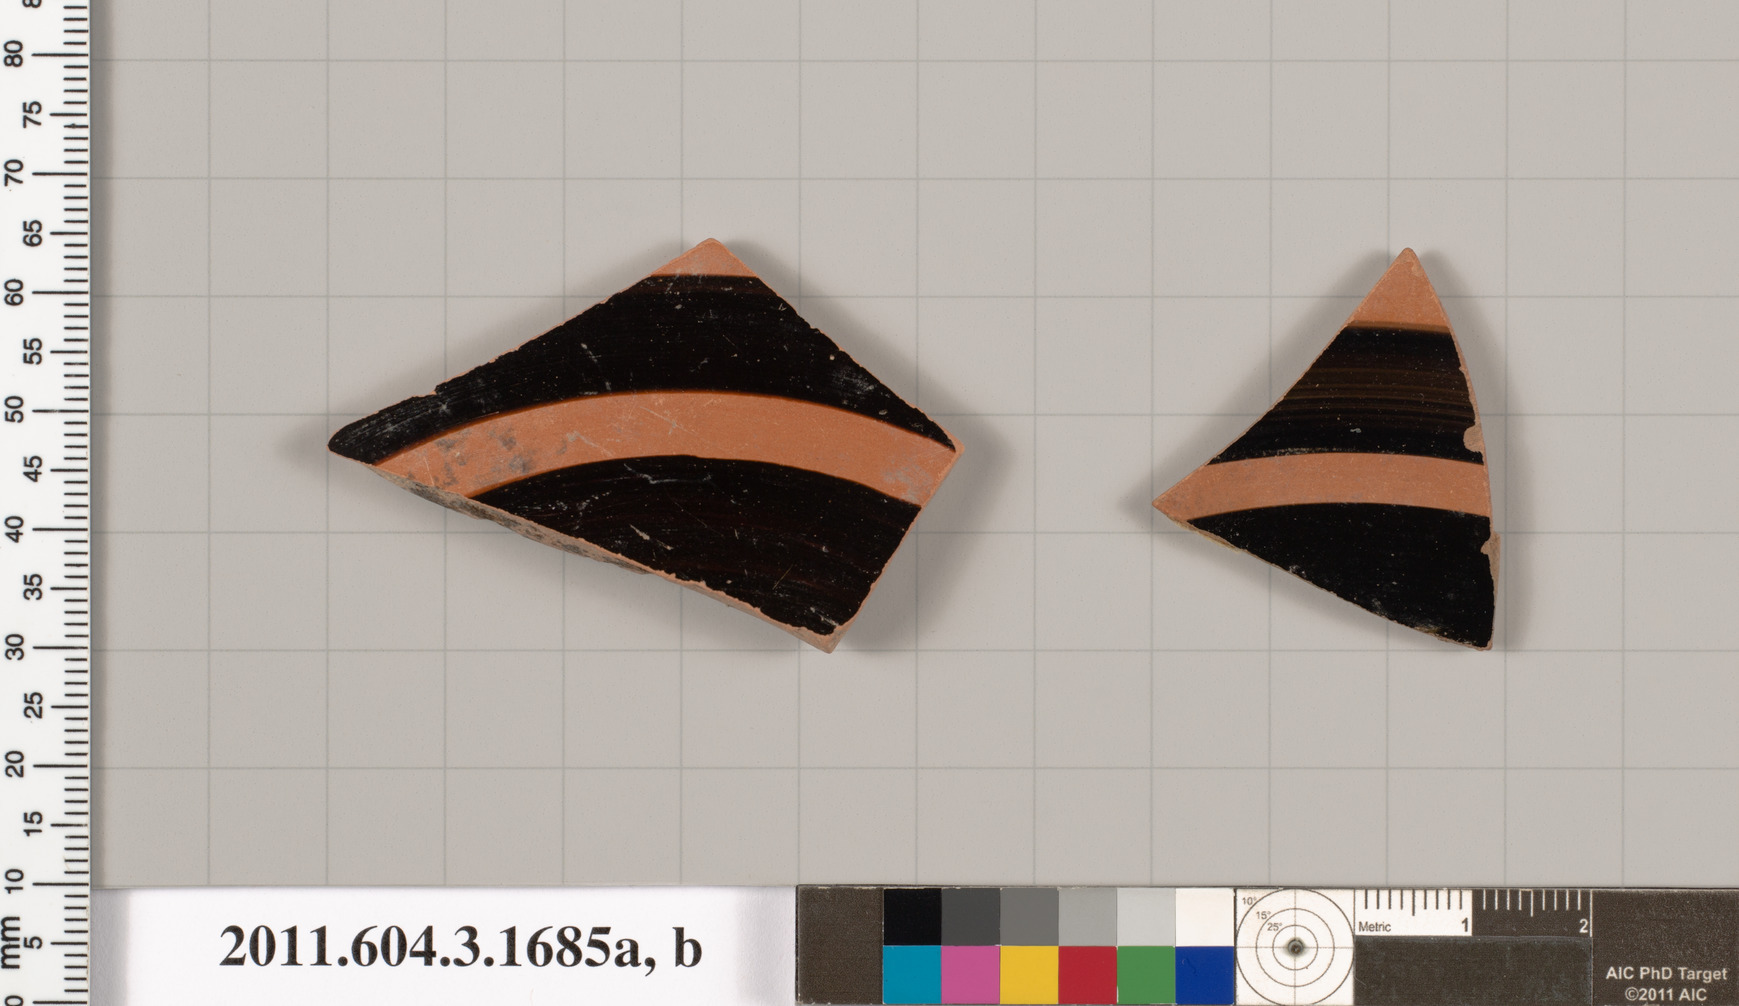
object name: kylix fragment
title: Terracotta fragments of kylikes: Band or lip cups (drinking cups)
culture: greek, attic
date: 550-526 BCE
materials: terracotta